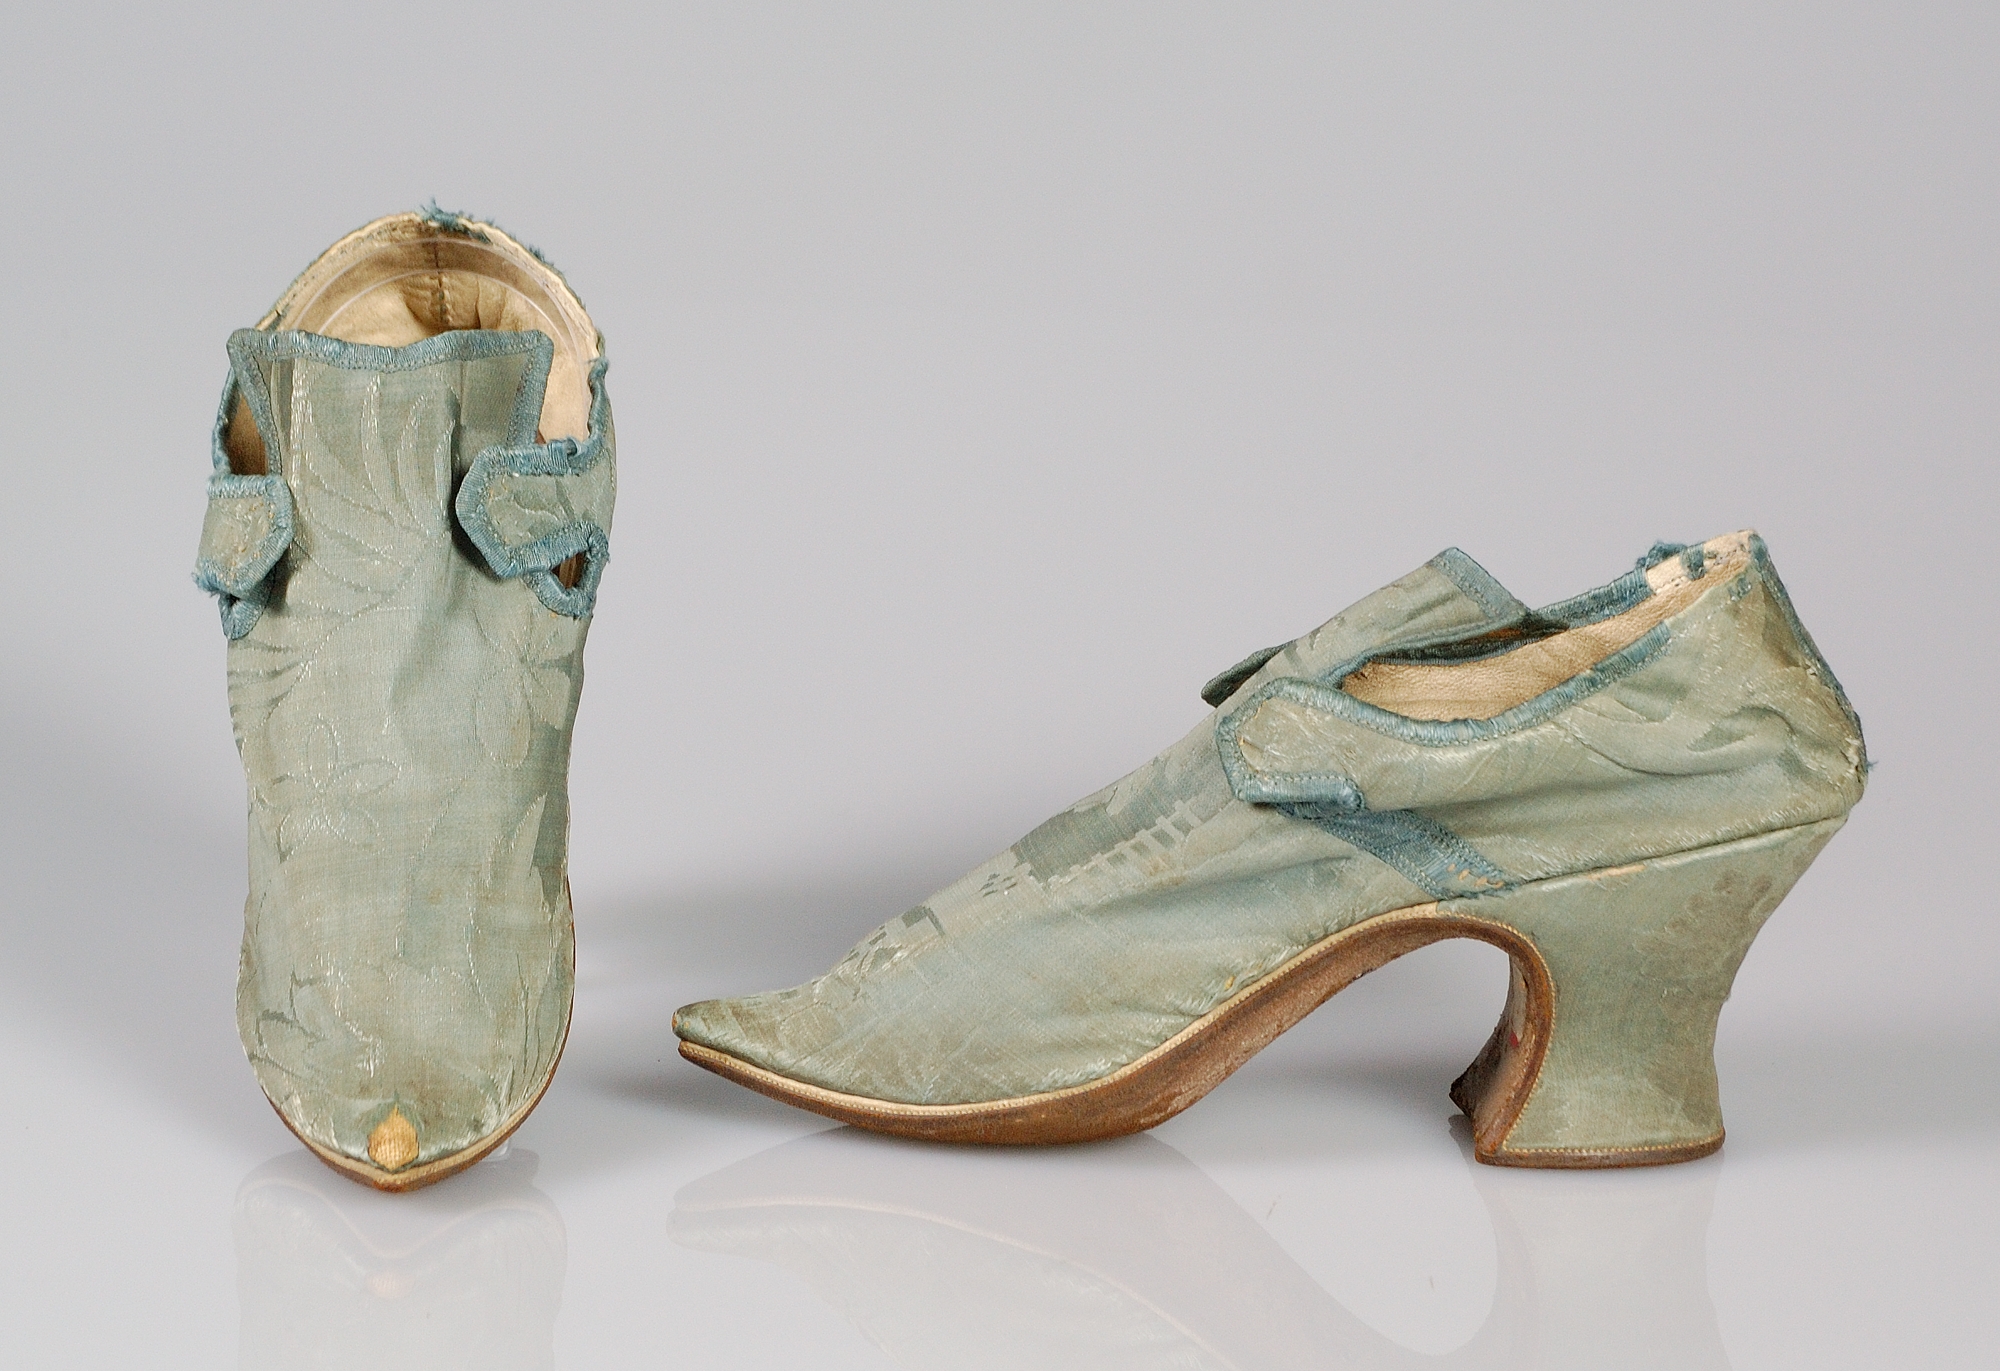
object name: shoe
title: Shoes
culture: european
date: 1690-1709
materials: silk